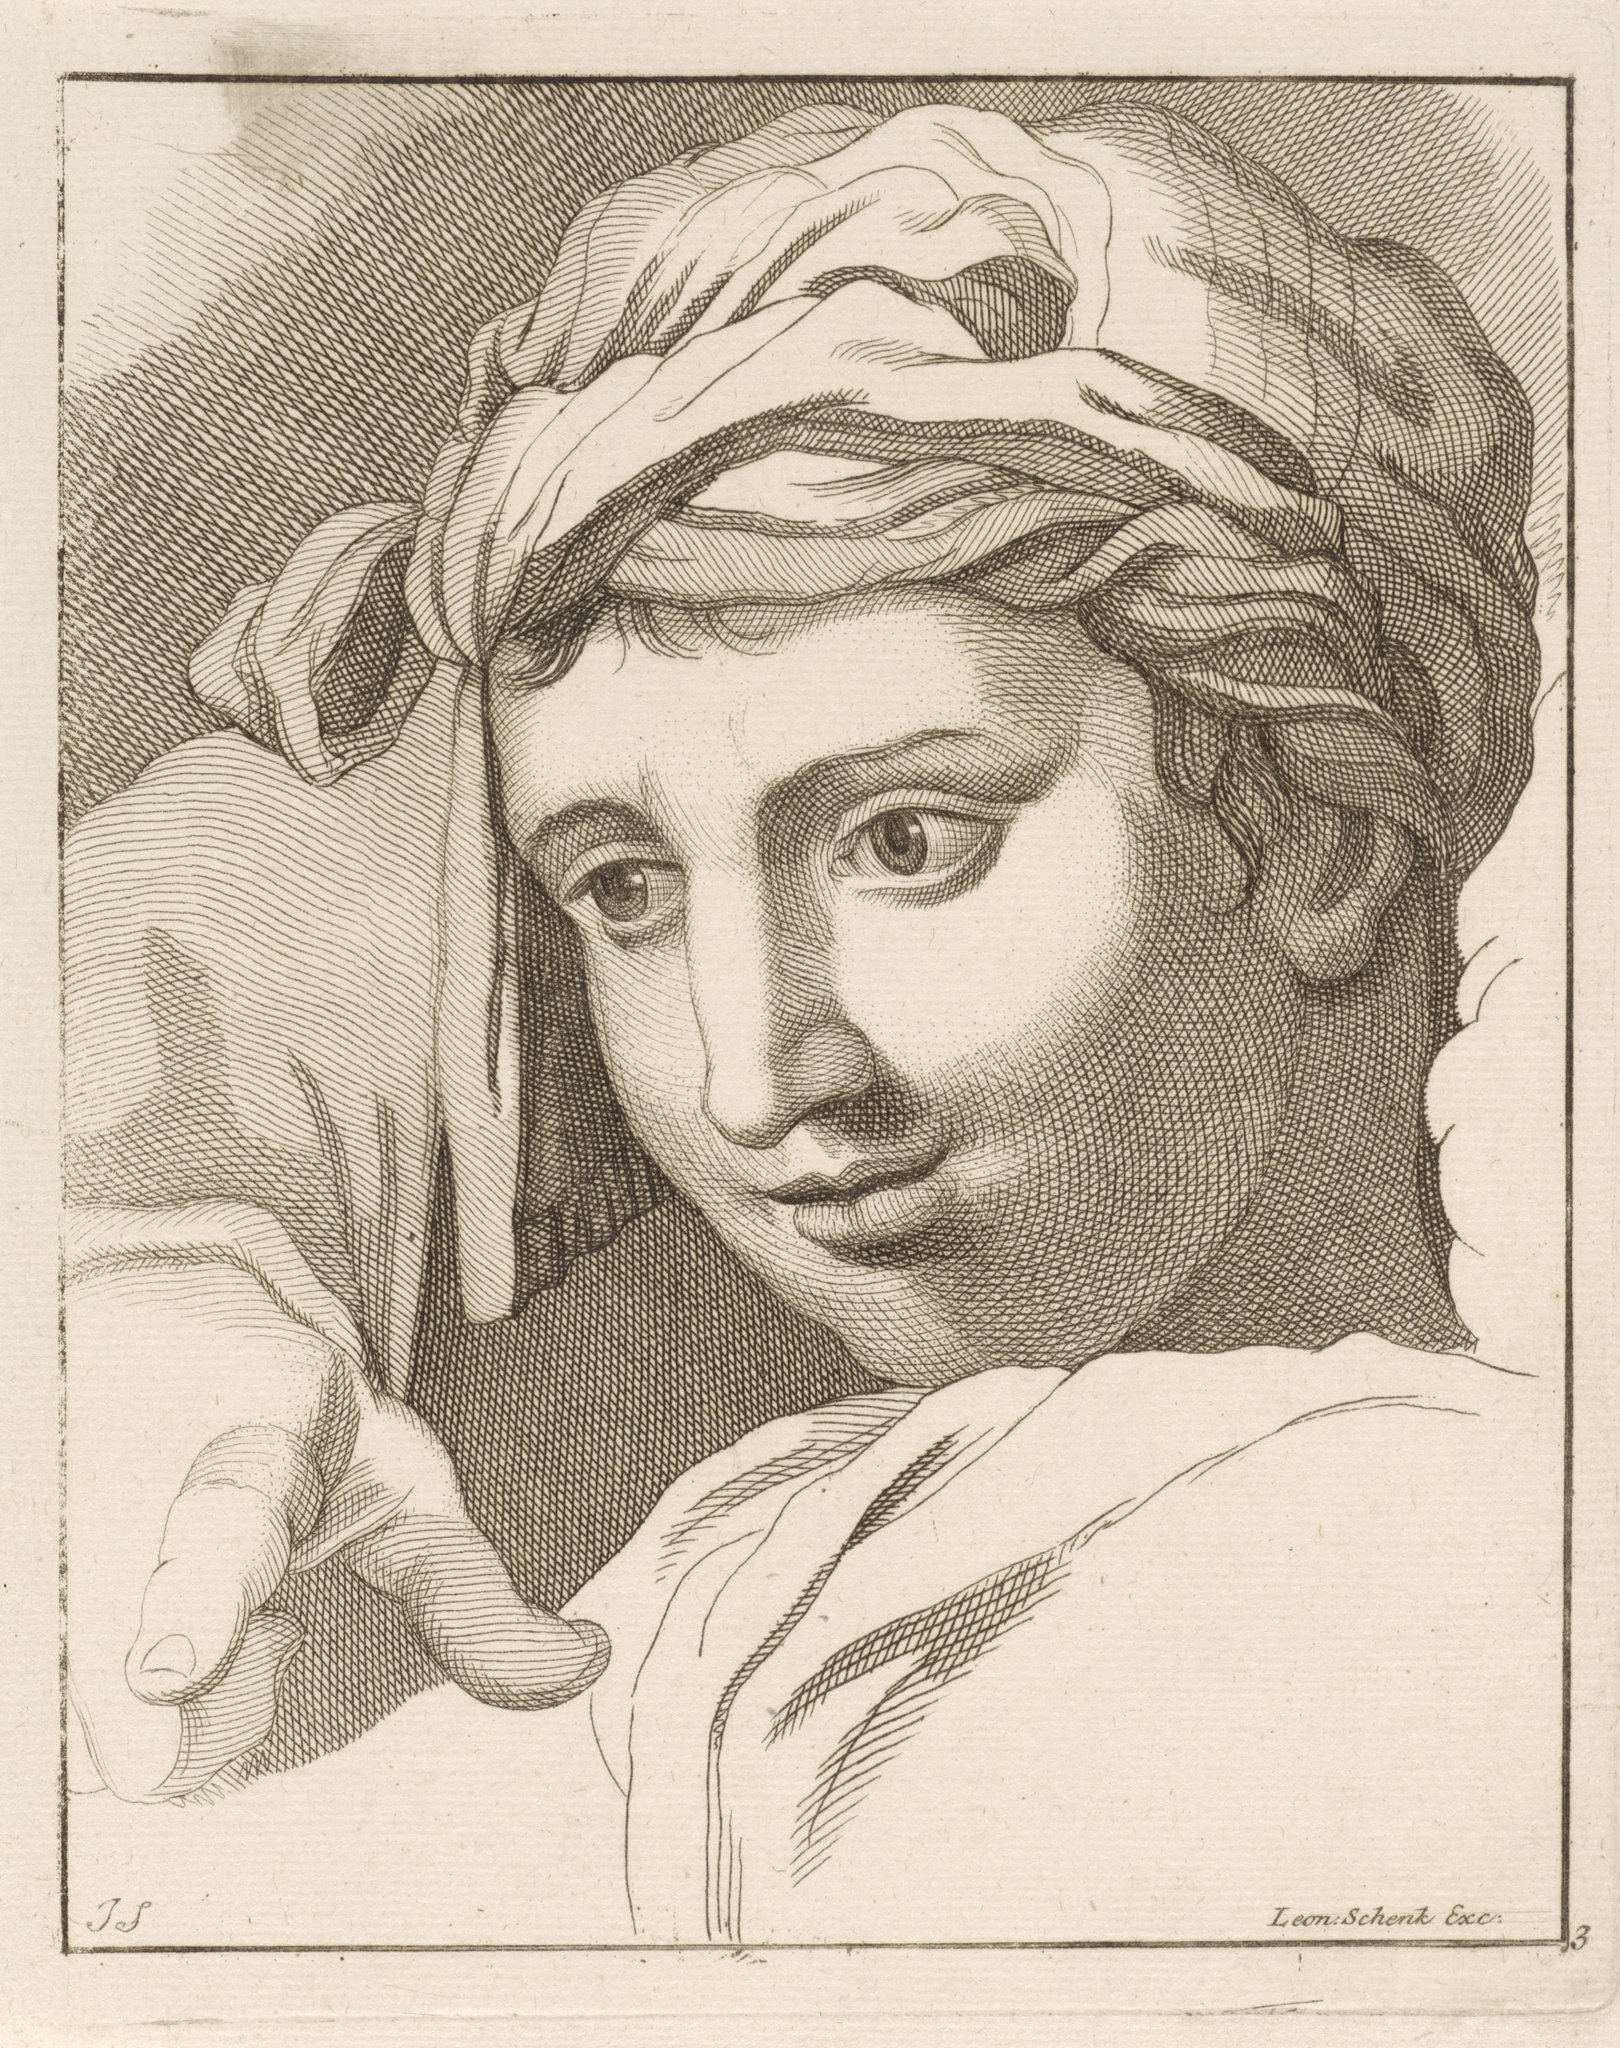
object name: print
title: Studie van een vrouwenhoofd(?) met een hoofddoek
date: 1710-1767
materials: paper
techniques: engraving, etching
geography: rome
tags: head (human) - aa - female human figure (+ three-quarter view), head (human) (+ three-quarter view), veil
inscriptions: collector's mark: Lugt 2228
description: Studie van een vrouwenhoofd(?) met een hoofddoek en opgeheven arm, driekwart naar links.